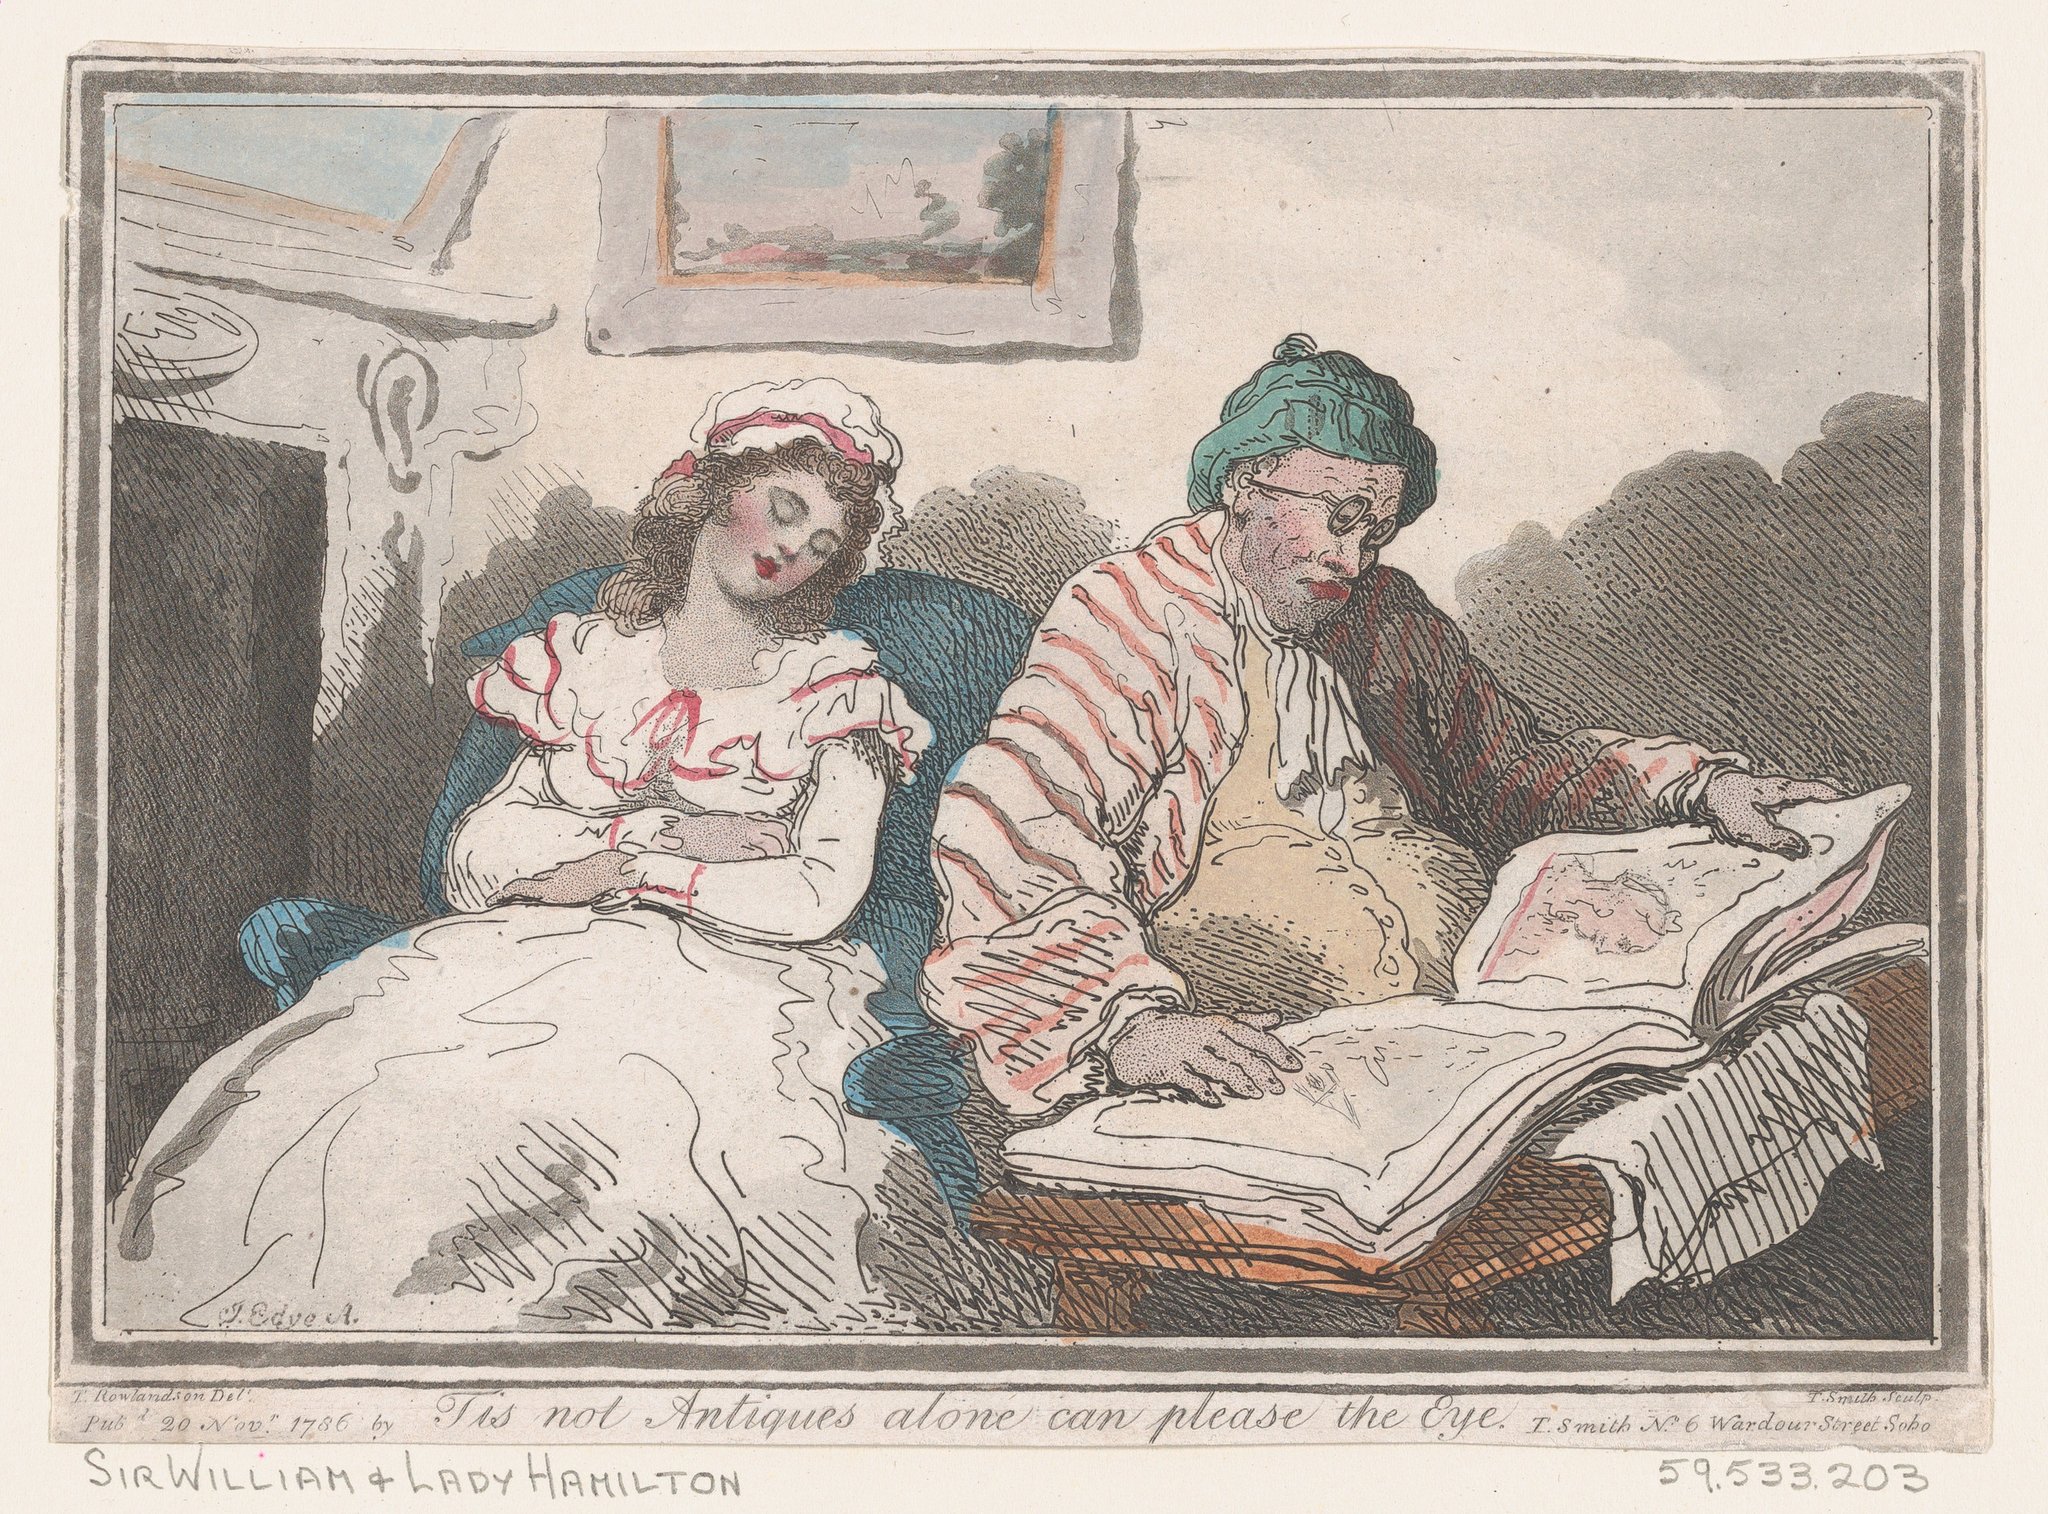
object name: print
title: 'Tis not Antiques Alone can Please the Eye, or Tastes Differ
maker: thomas rowlandson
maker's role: artist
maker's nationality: british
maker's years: 1757-1827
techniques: etching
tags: sleeping,men,women,reading